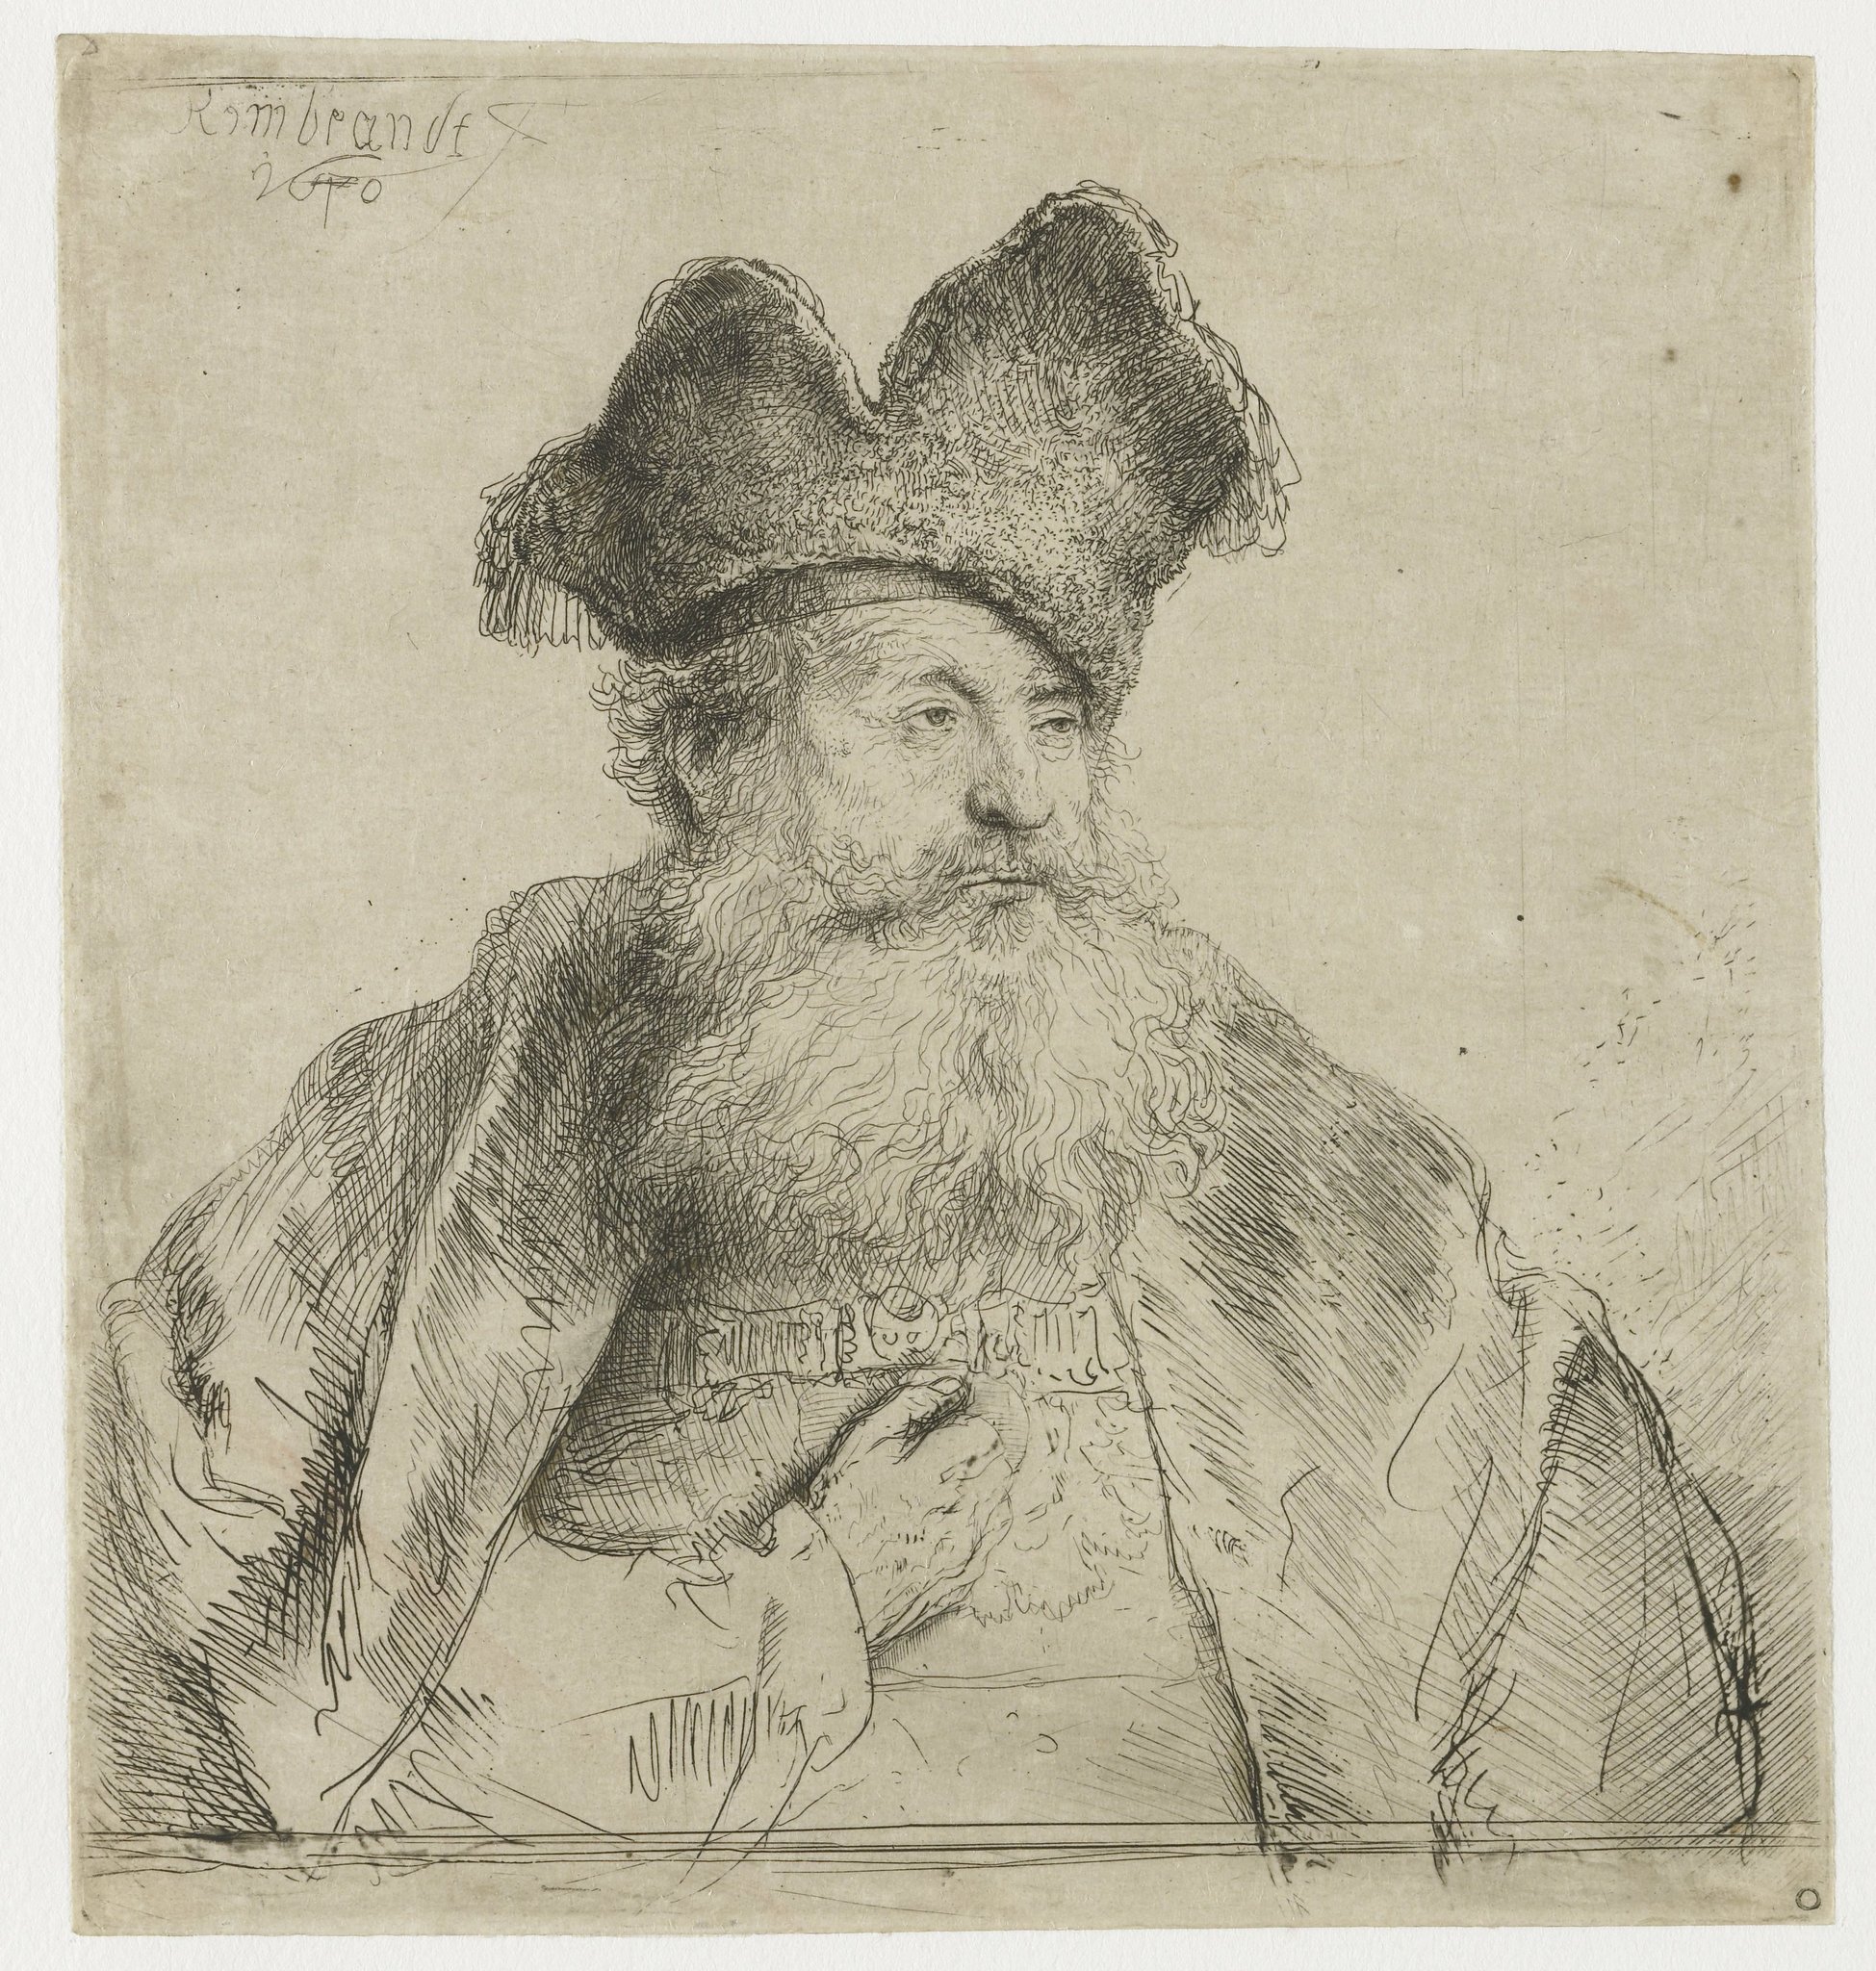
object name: print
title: Old man with a divided fur cap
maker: rembrandt van rijn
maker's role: draughtsman, painter, print maker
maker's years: 1606-1669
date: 1640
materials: paper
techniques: drypoint, etching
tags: head-gear (with name)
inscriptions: signature and date: ‘Rembrandt f 1640’, inscription: ‘o’ Lugt 2923 b, mark: Lugt 1296, mark: Lugt 2228